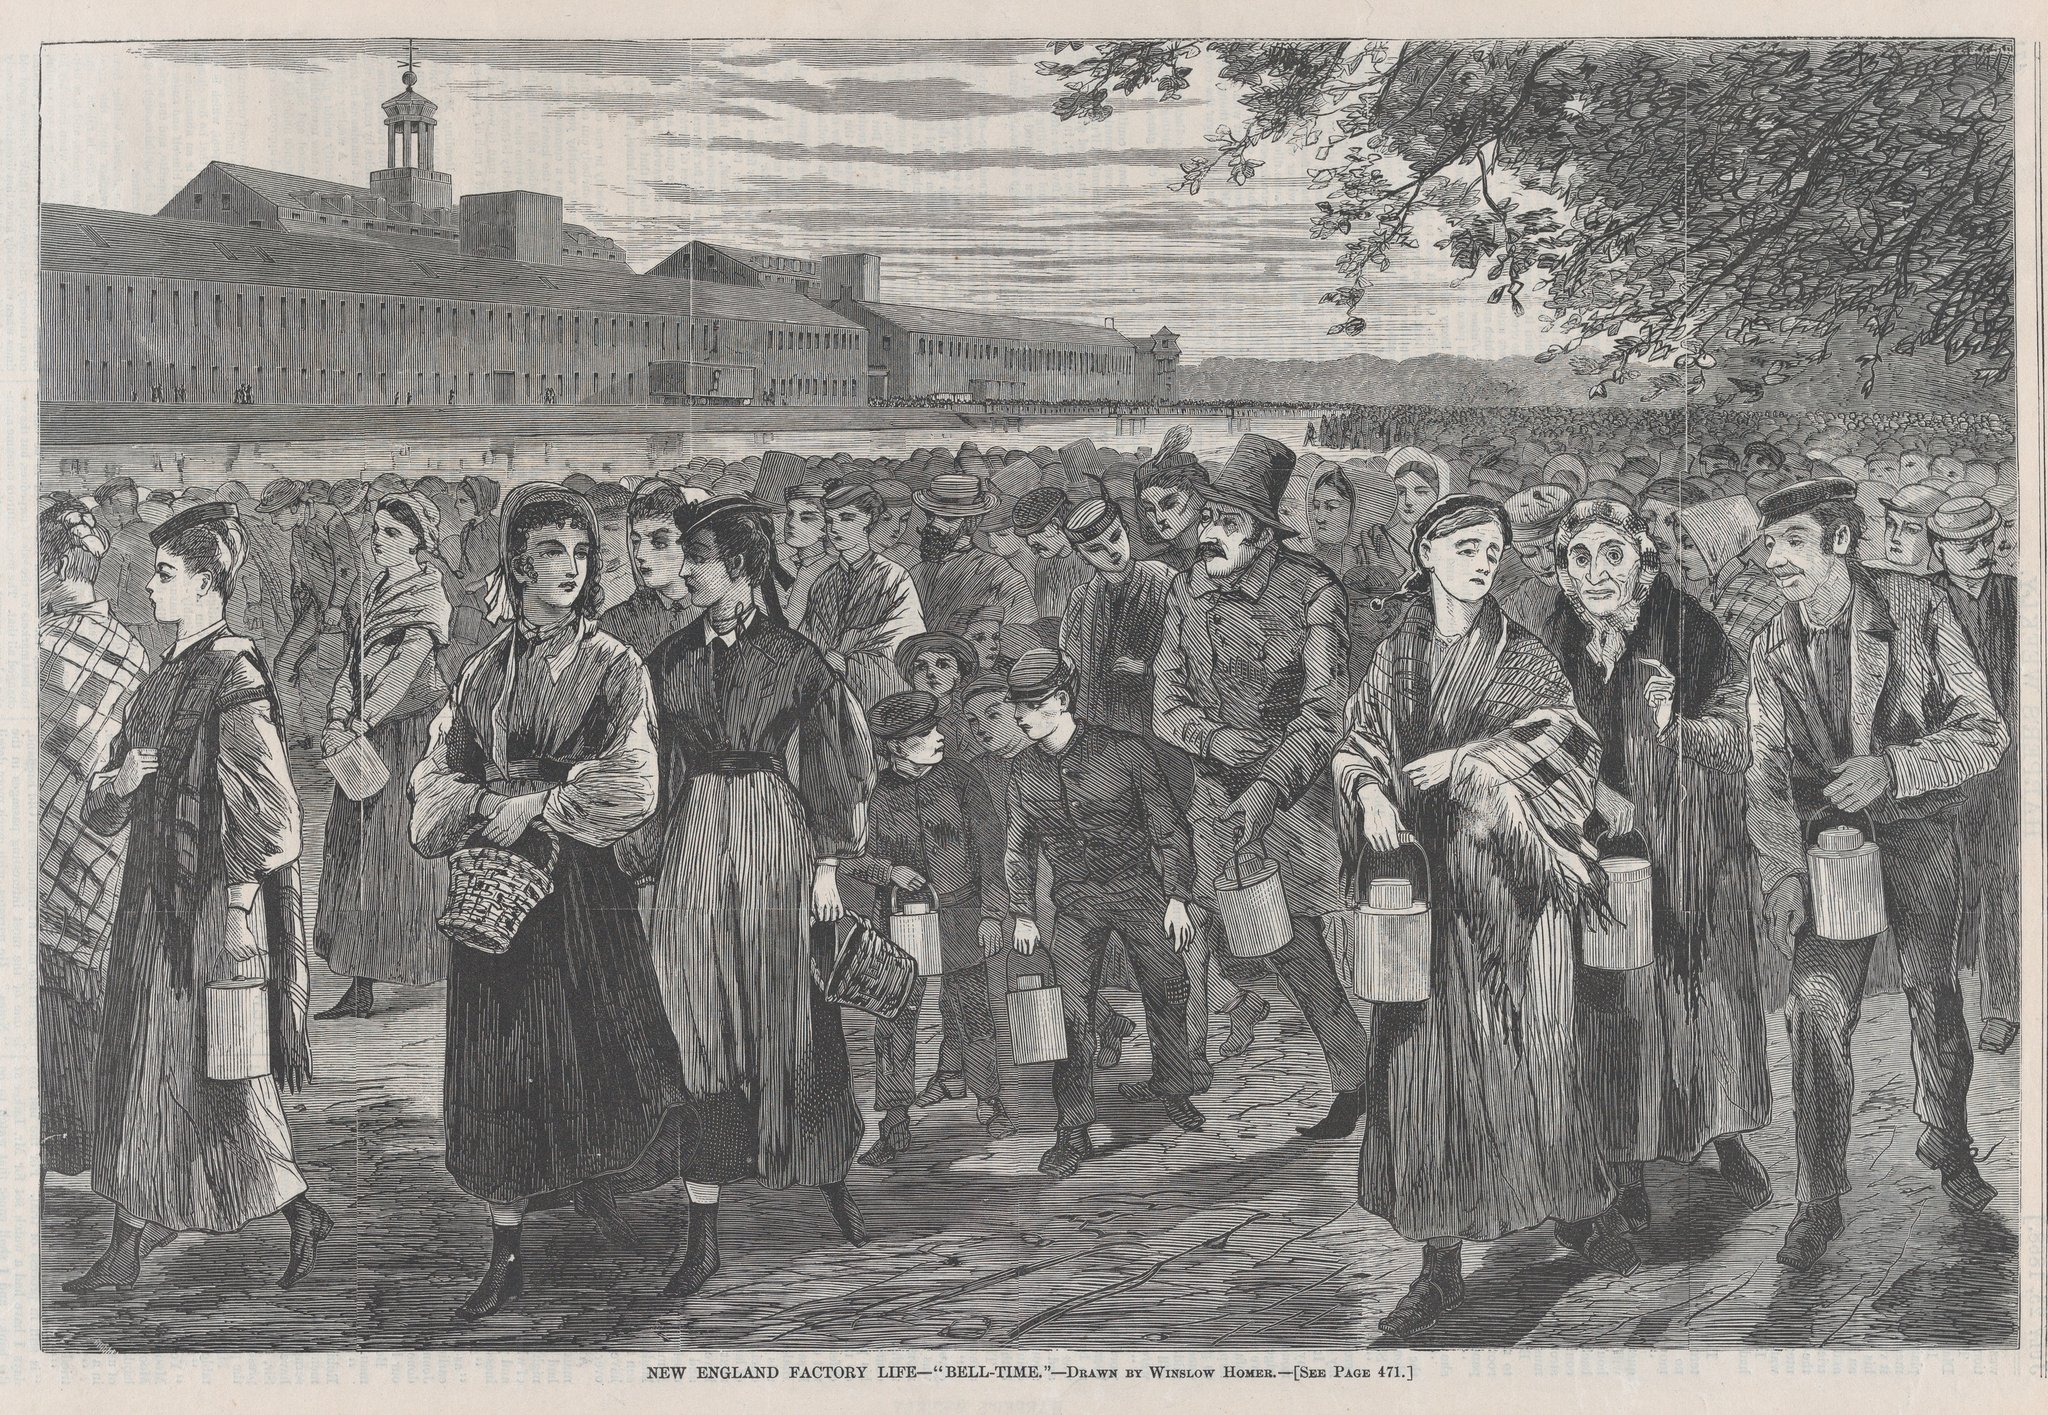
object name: print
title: New England Factory Life – "Bell Time" (from "Harper's Weekly," Vol. XII)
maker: winslow homer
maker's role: artist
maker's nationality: american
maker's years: 1836-1910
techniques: engraving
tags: factories,boys,men,women,crowd